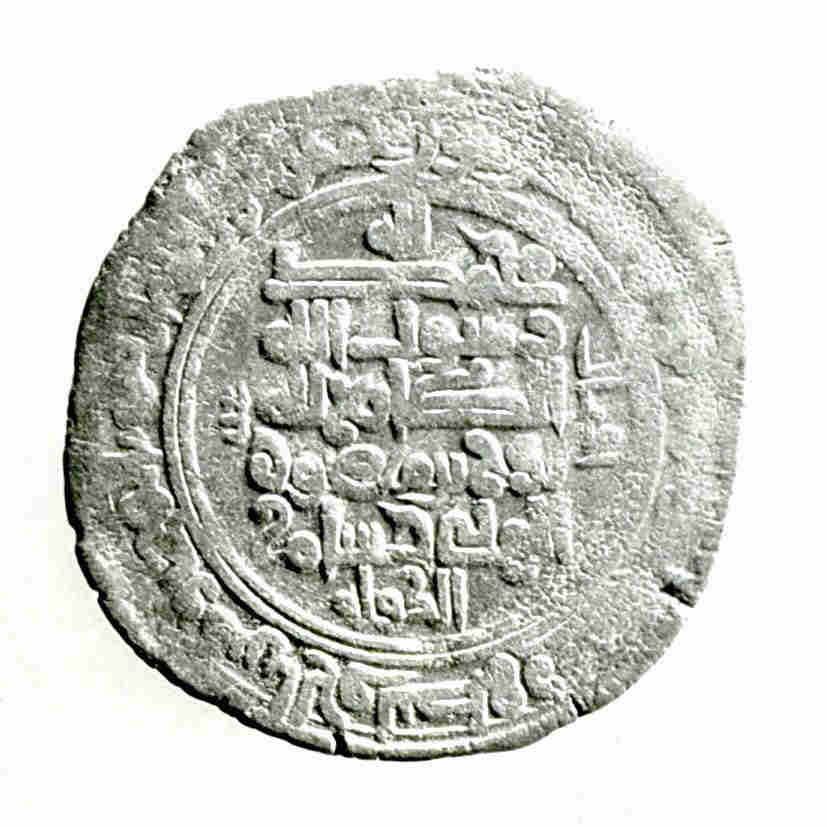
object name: coin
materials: silver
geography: iran